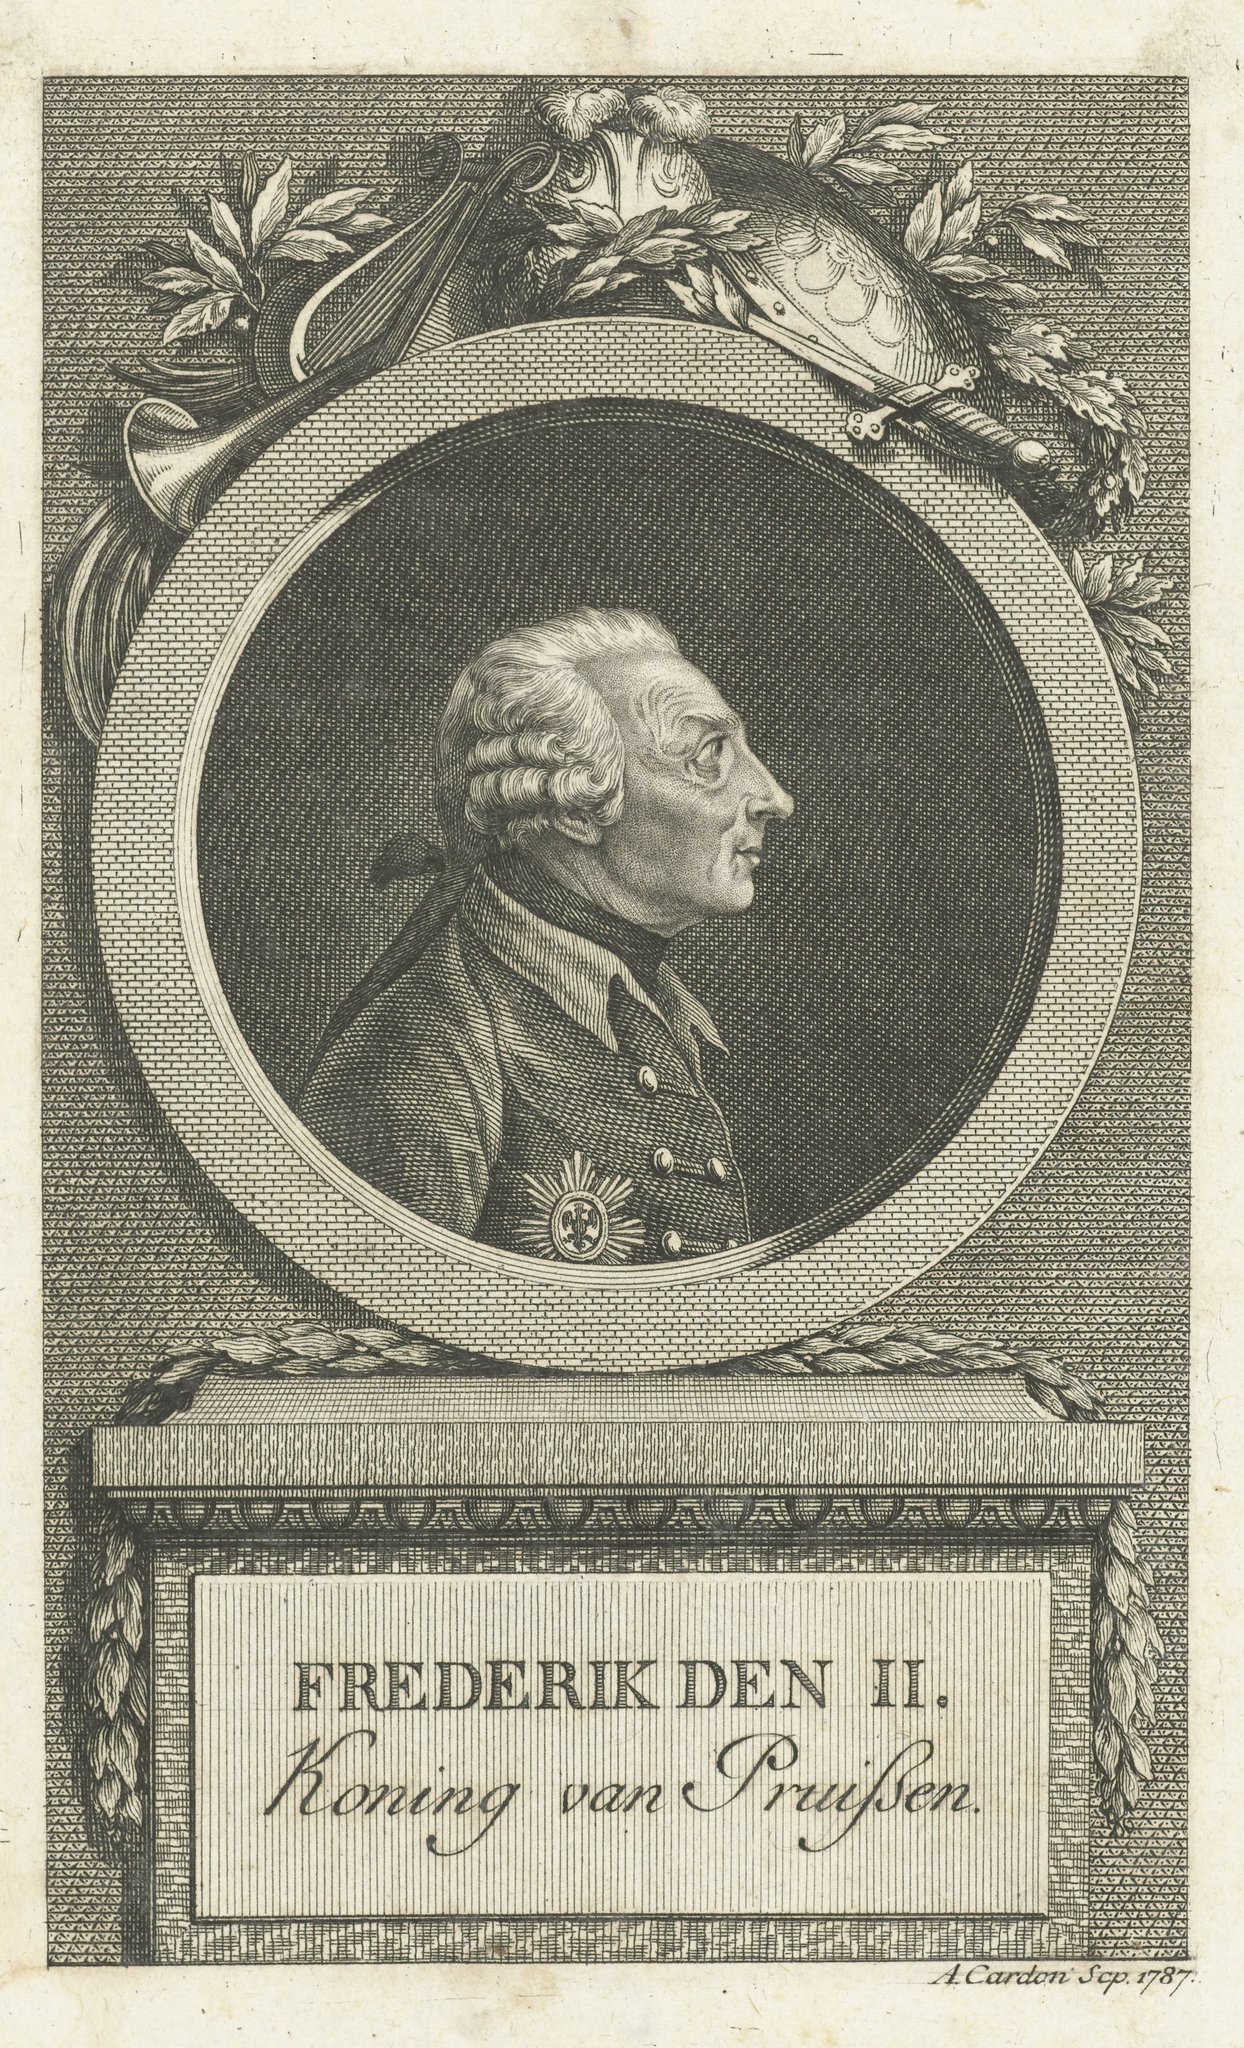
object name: print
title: Portret van Frederik de Grote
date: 1787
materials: paper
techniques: etching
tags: berlin, frederick ii (king of prussia)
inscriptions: collector's mark: Lugt 2228